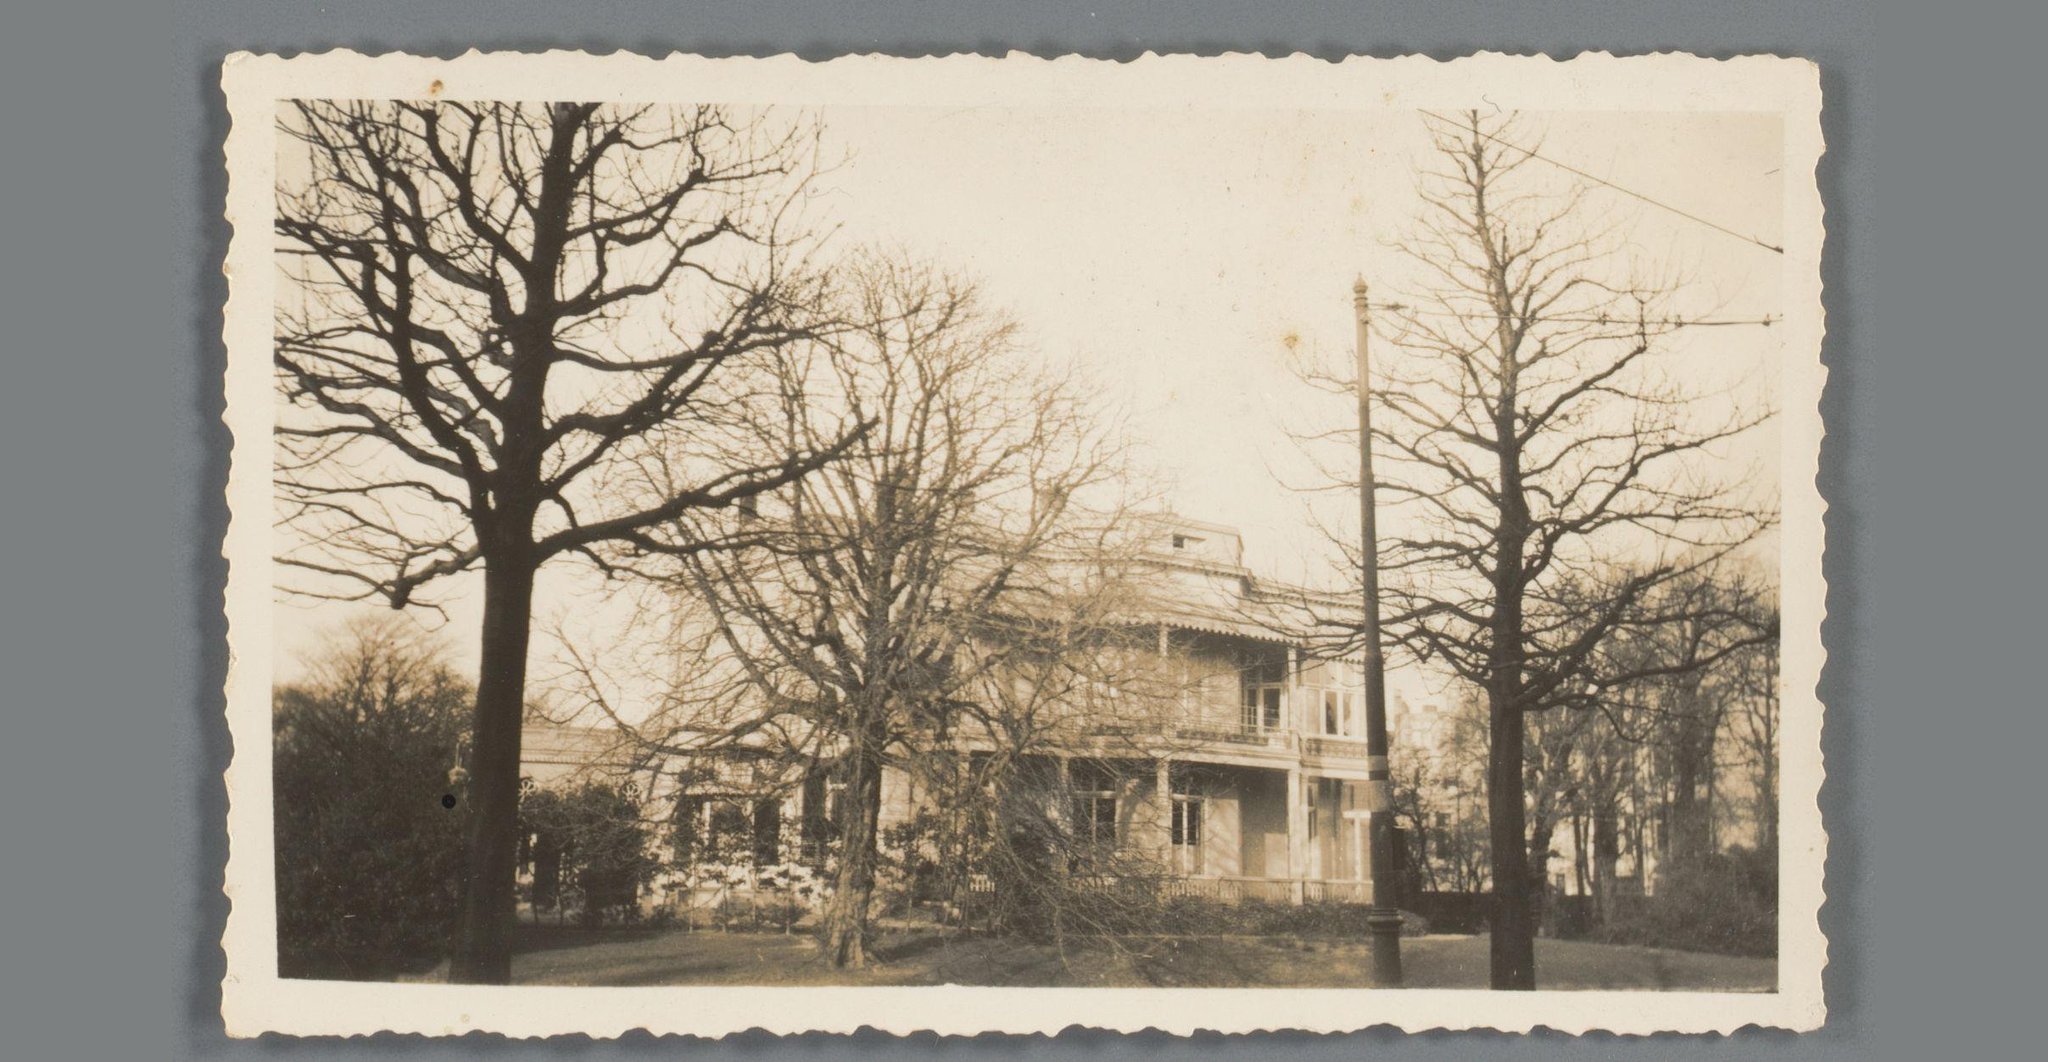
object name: photograph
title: Gezicht op een vrijstaand huis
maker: Anonymous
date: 1900-1920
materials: paper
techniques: gelatin silver print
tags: villa